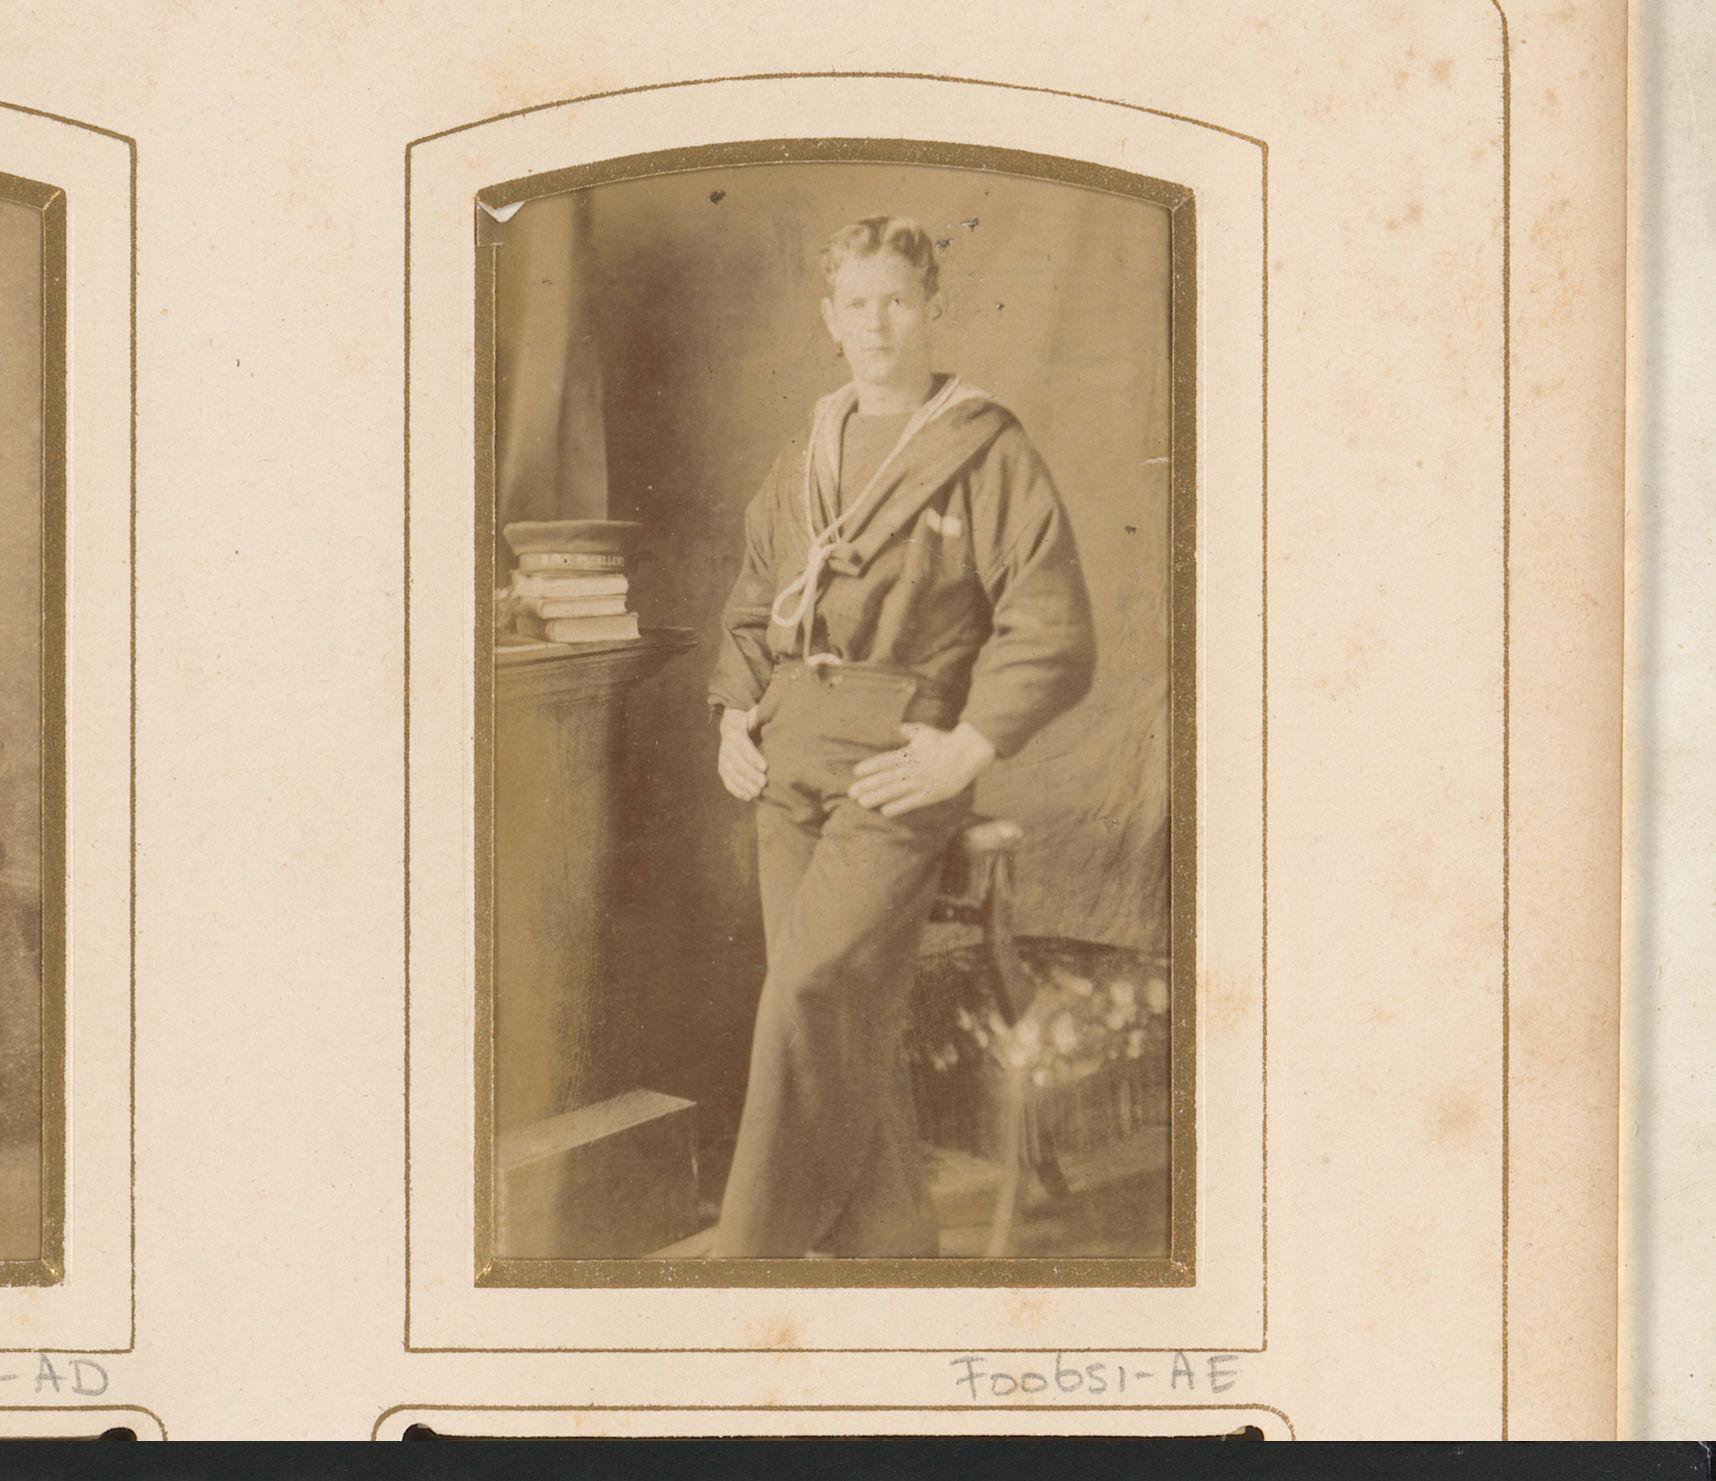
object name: album leaf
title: Portret van een matroos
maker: Anonymous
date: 1880-1915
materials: cardboard, photographic support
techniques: albumen print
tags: adult man, historical persons, seaman